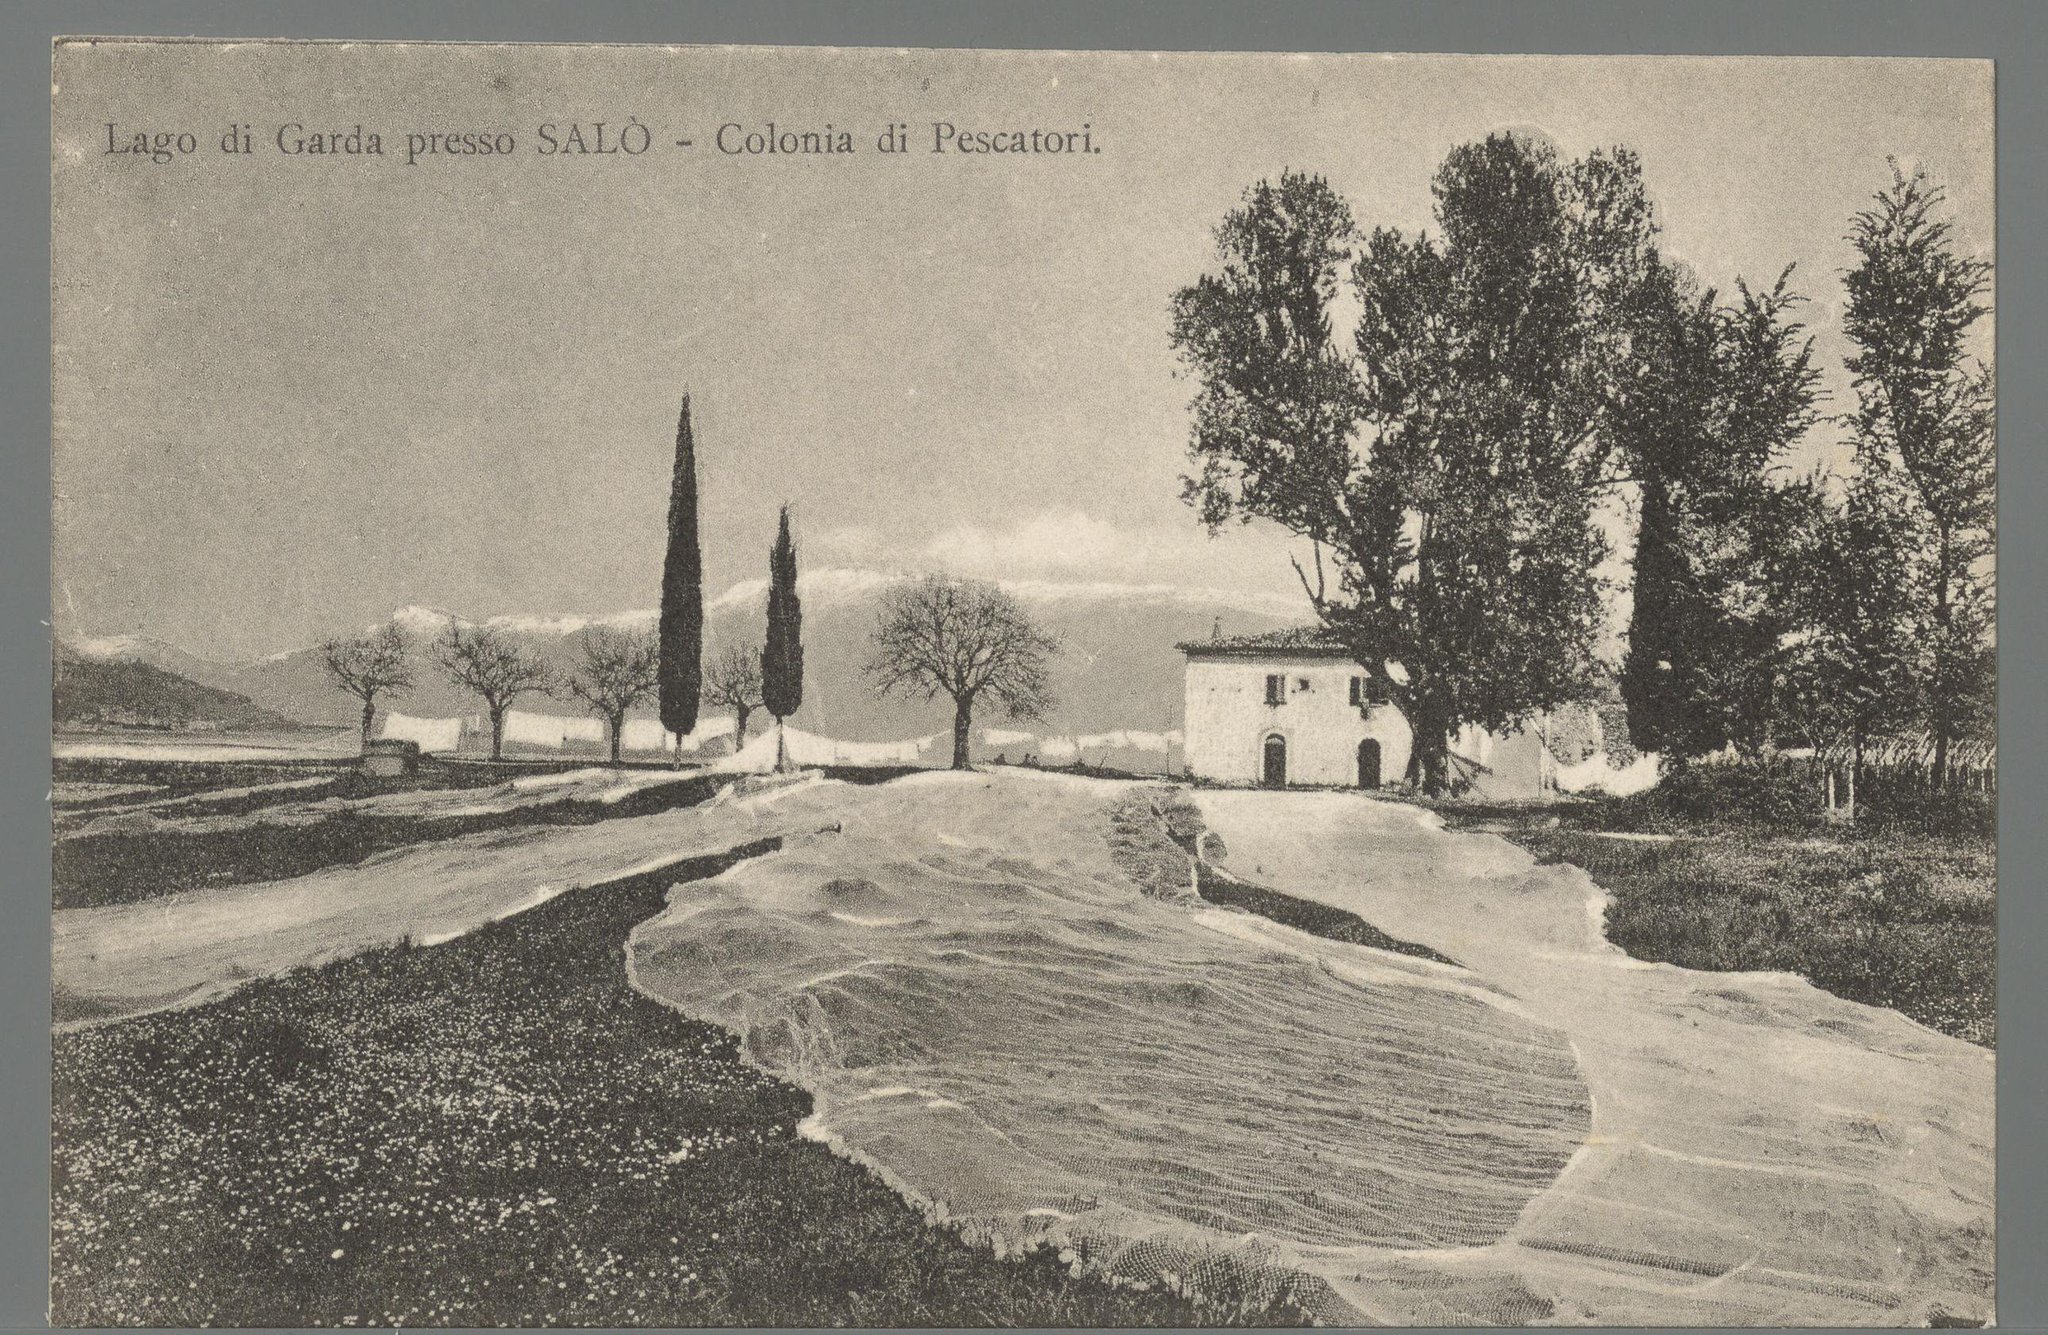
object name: ansichtkaart, prentbriefkaart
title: Lago di Garda presso Salò. Colonia di Pescatori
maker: Anonymous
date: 1906-1930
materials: cardboard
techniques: photograph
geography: salò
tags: fishing net, cottage, mountains